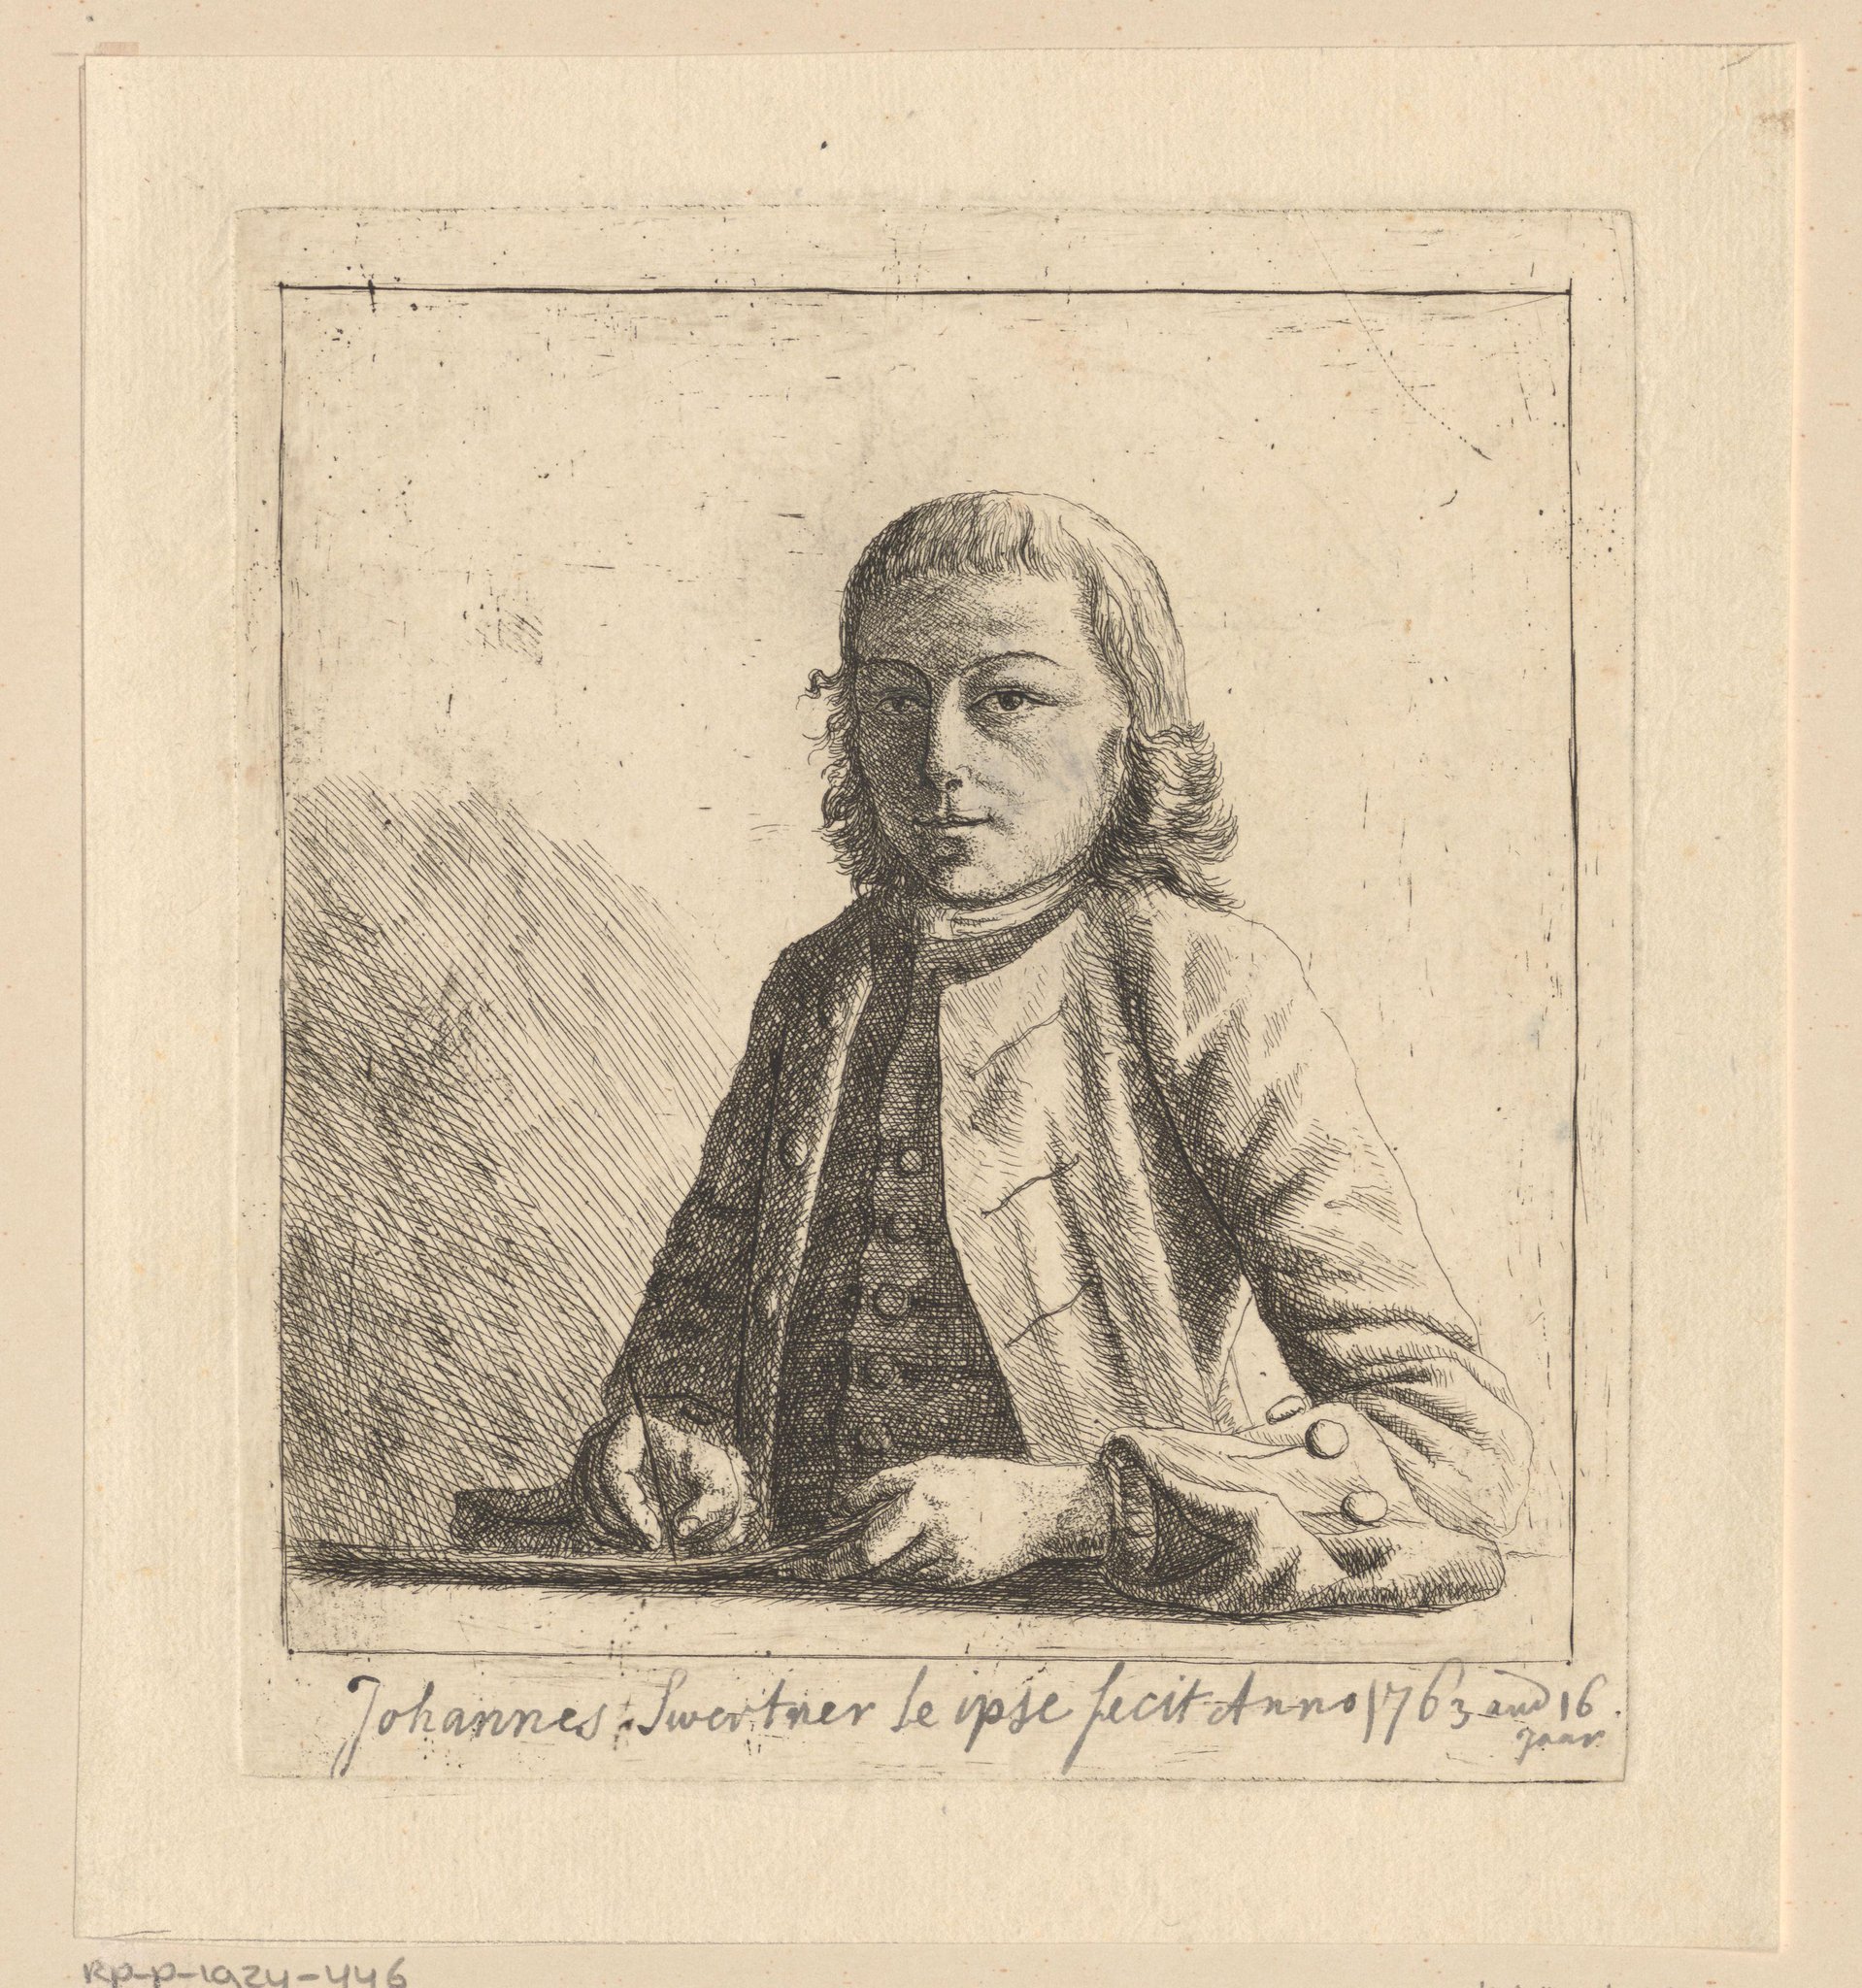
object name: print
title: Zelfportret op 16-jarige leeftijd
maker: johannes swertner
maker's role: draughtsman, painter, print maker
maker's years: 1746-1813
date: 1763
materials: paper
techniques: etching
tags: haarlem, painter, print maker, draughtsman, johannes swertner, historical persons, portrait, self-portrait of graphic artist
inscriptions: collector's mark: Lugt 2233, inscription: ‘Johannes Swertner se ipse fecit Anno 1763 oud 16 jaar’